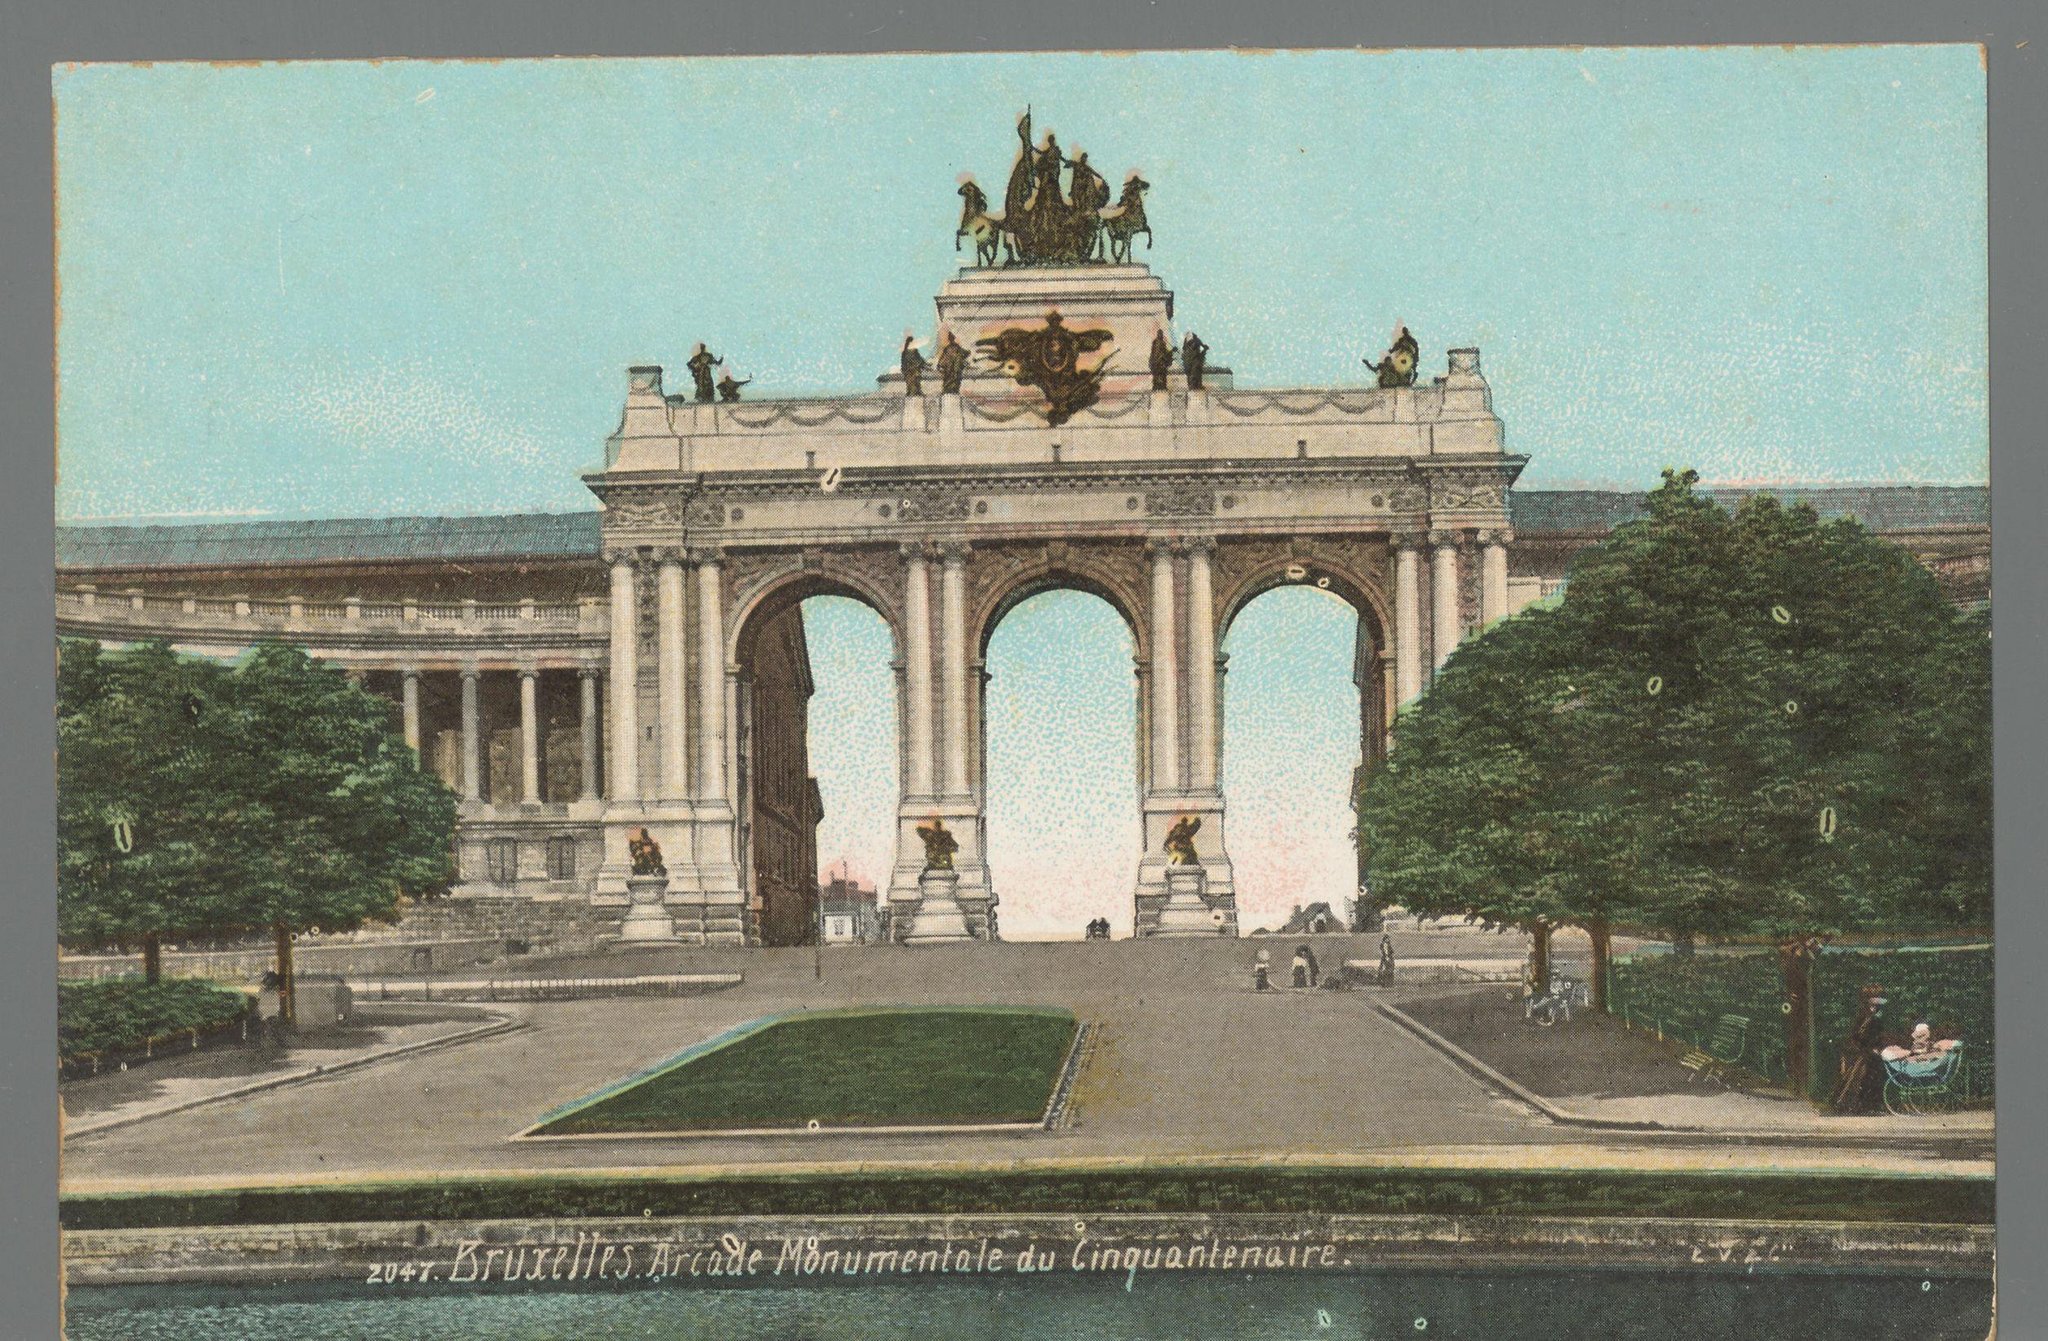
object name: ansichtkaart, prentbriefkaart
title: Bruxelles. Arcade Monumentale du Cinquantenaire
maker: Anonymous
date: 1906-1920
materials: cardboard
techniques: lithograph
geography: brussels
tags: park, gate, entrance, monument, statue